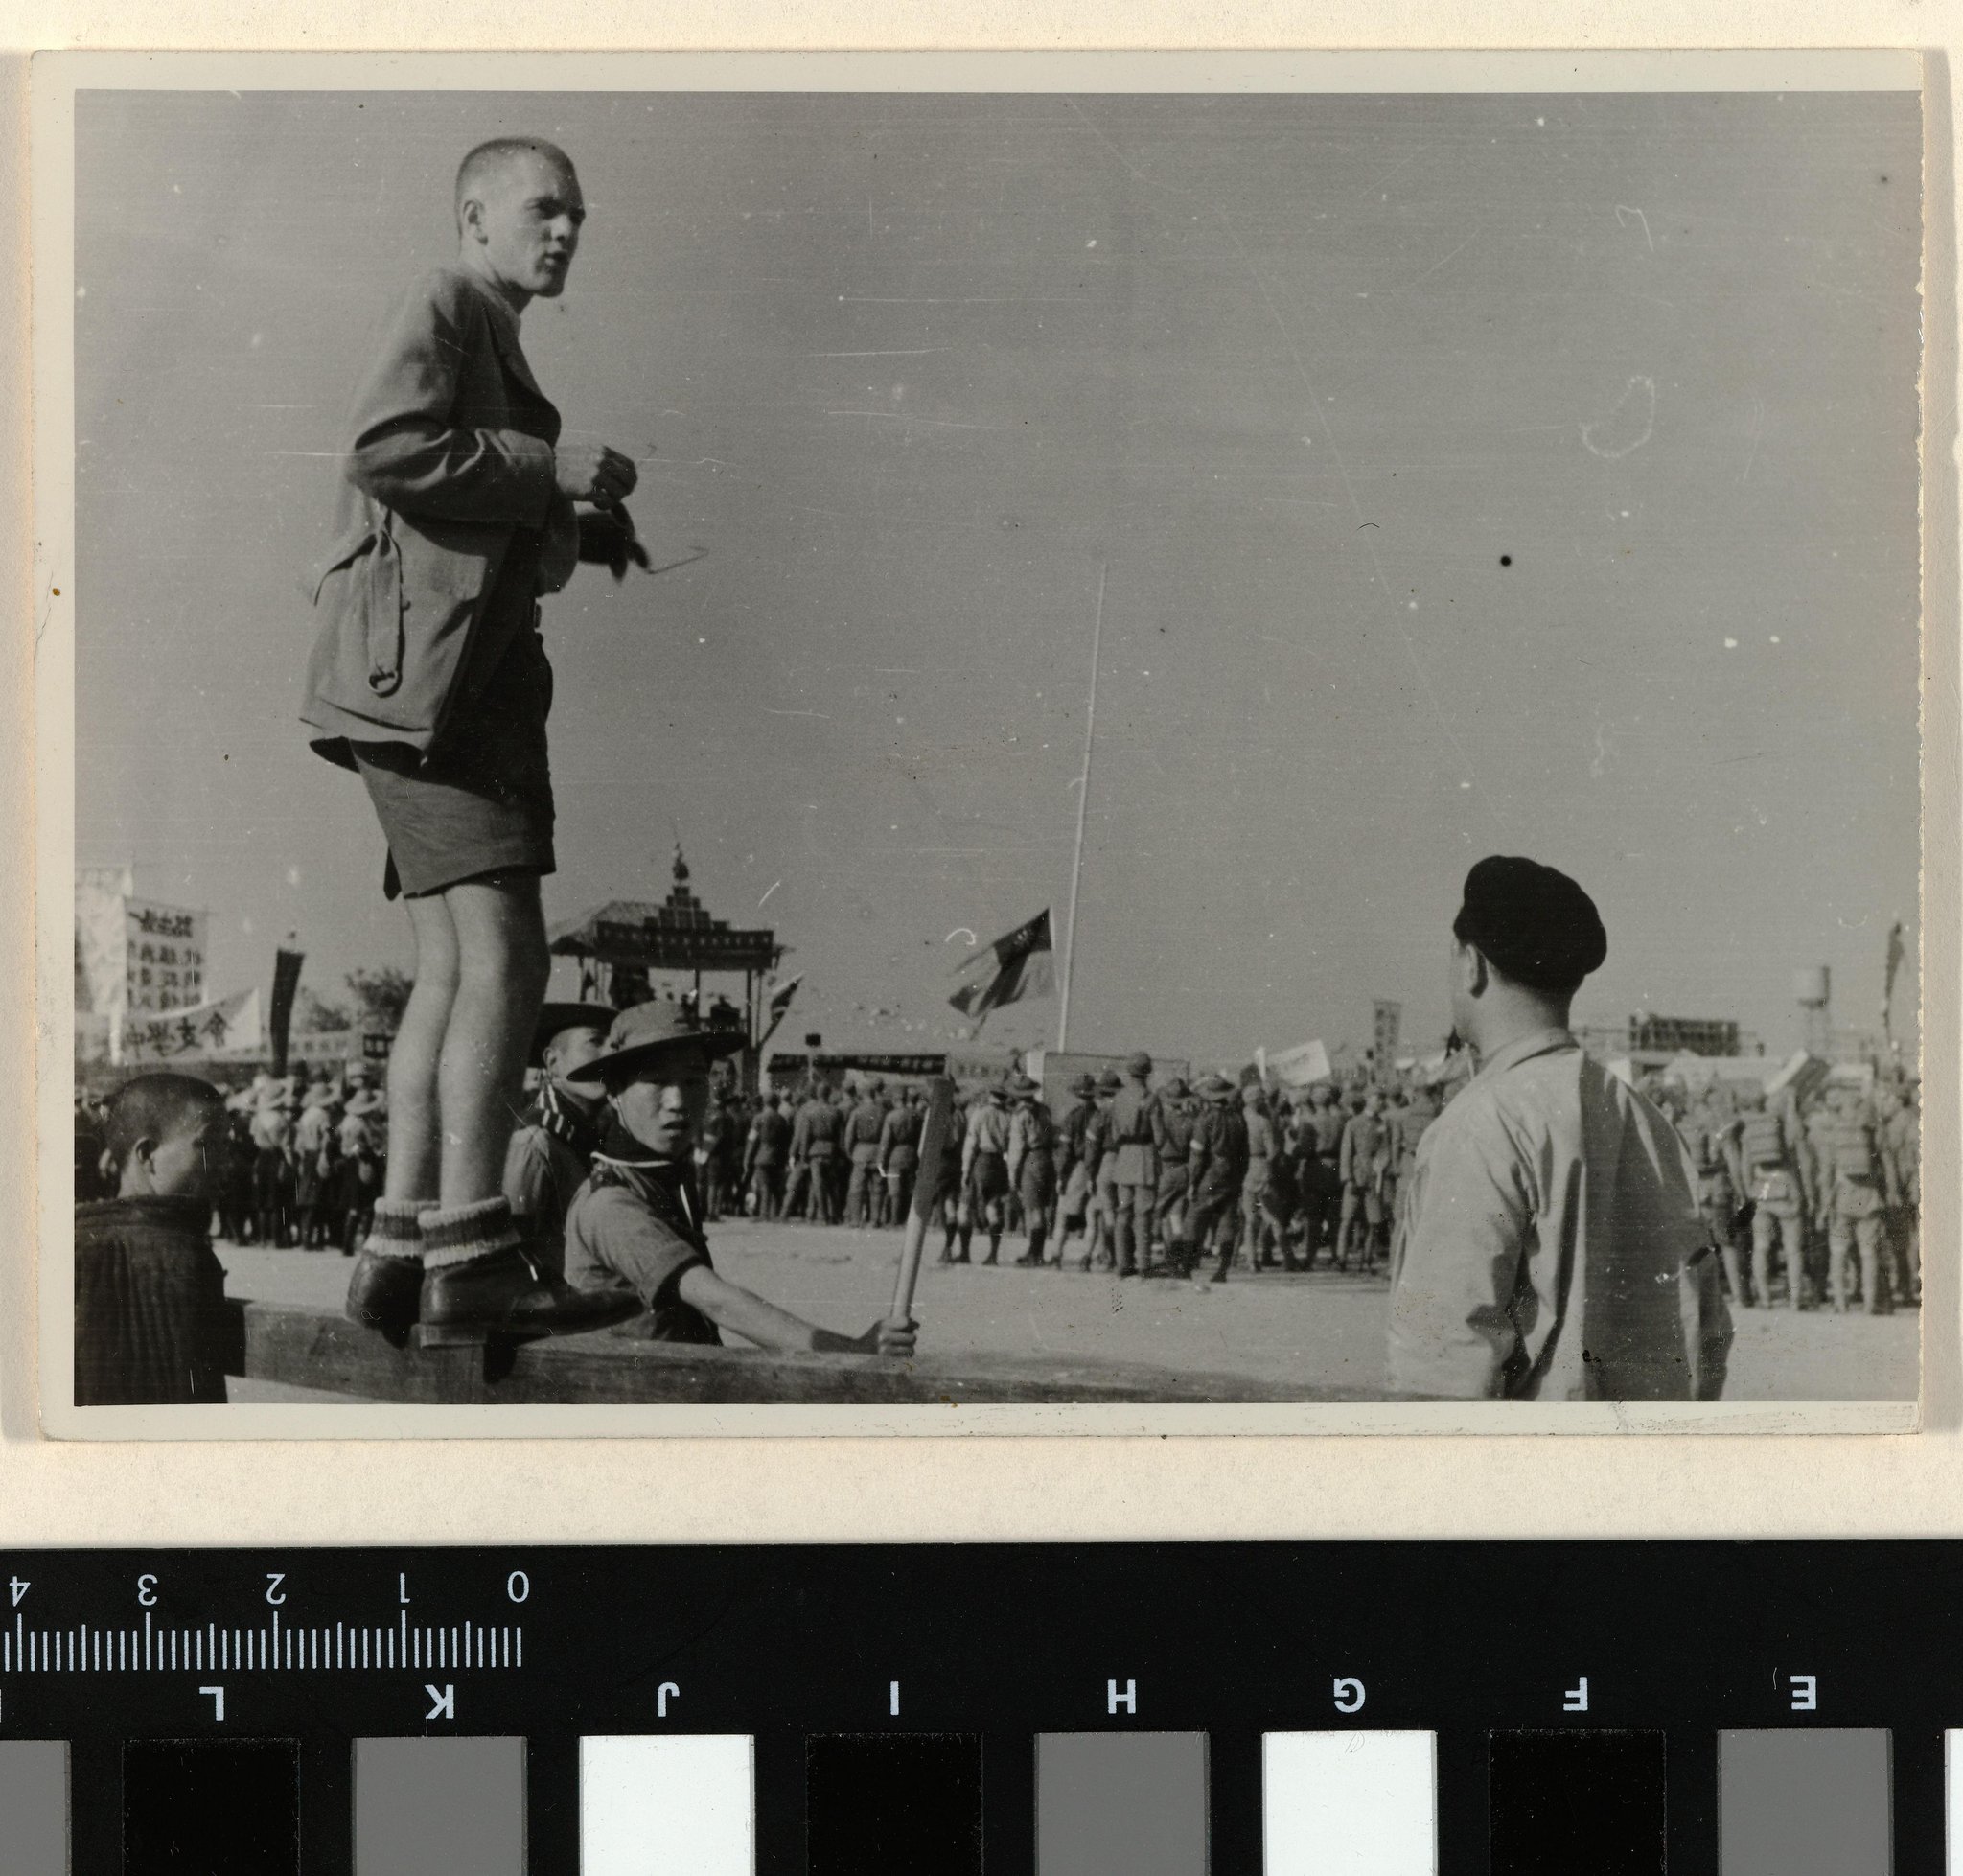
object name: photograph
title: John Fernhout kijkt naar marcherende Chinese soldaten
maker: robert capa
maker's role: fotograaf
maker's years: 1913-1954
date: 1938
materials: paper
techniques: gelatin silver print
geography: china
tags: john fernhout, marching away (troops), filming, cinematographer at work - cc - out of doors, china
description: John Fernhout in een korte broek staat op een muur en kijkt naar een groep soldaten, China.